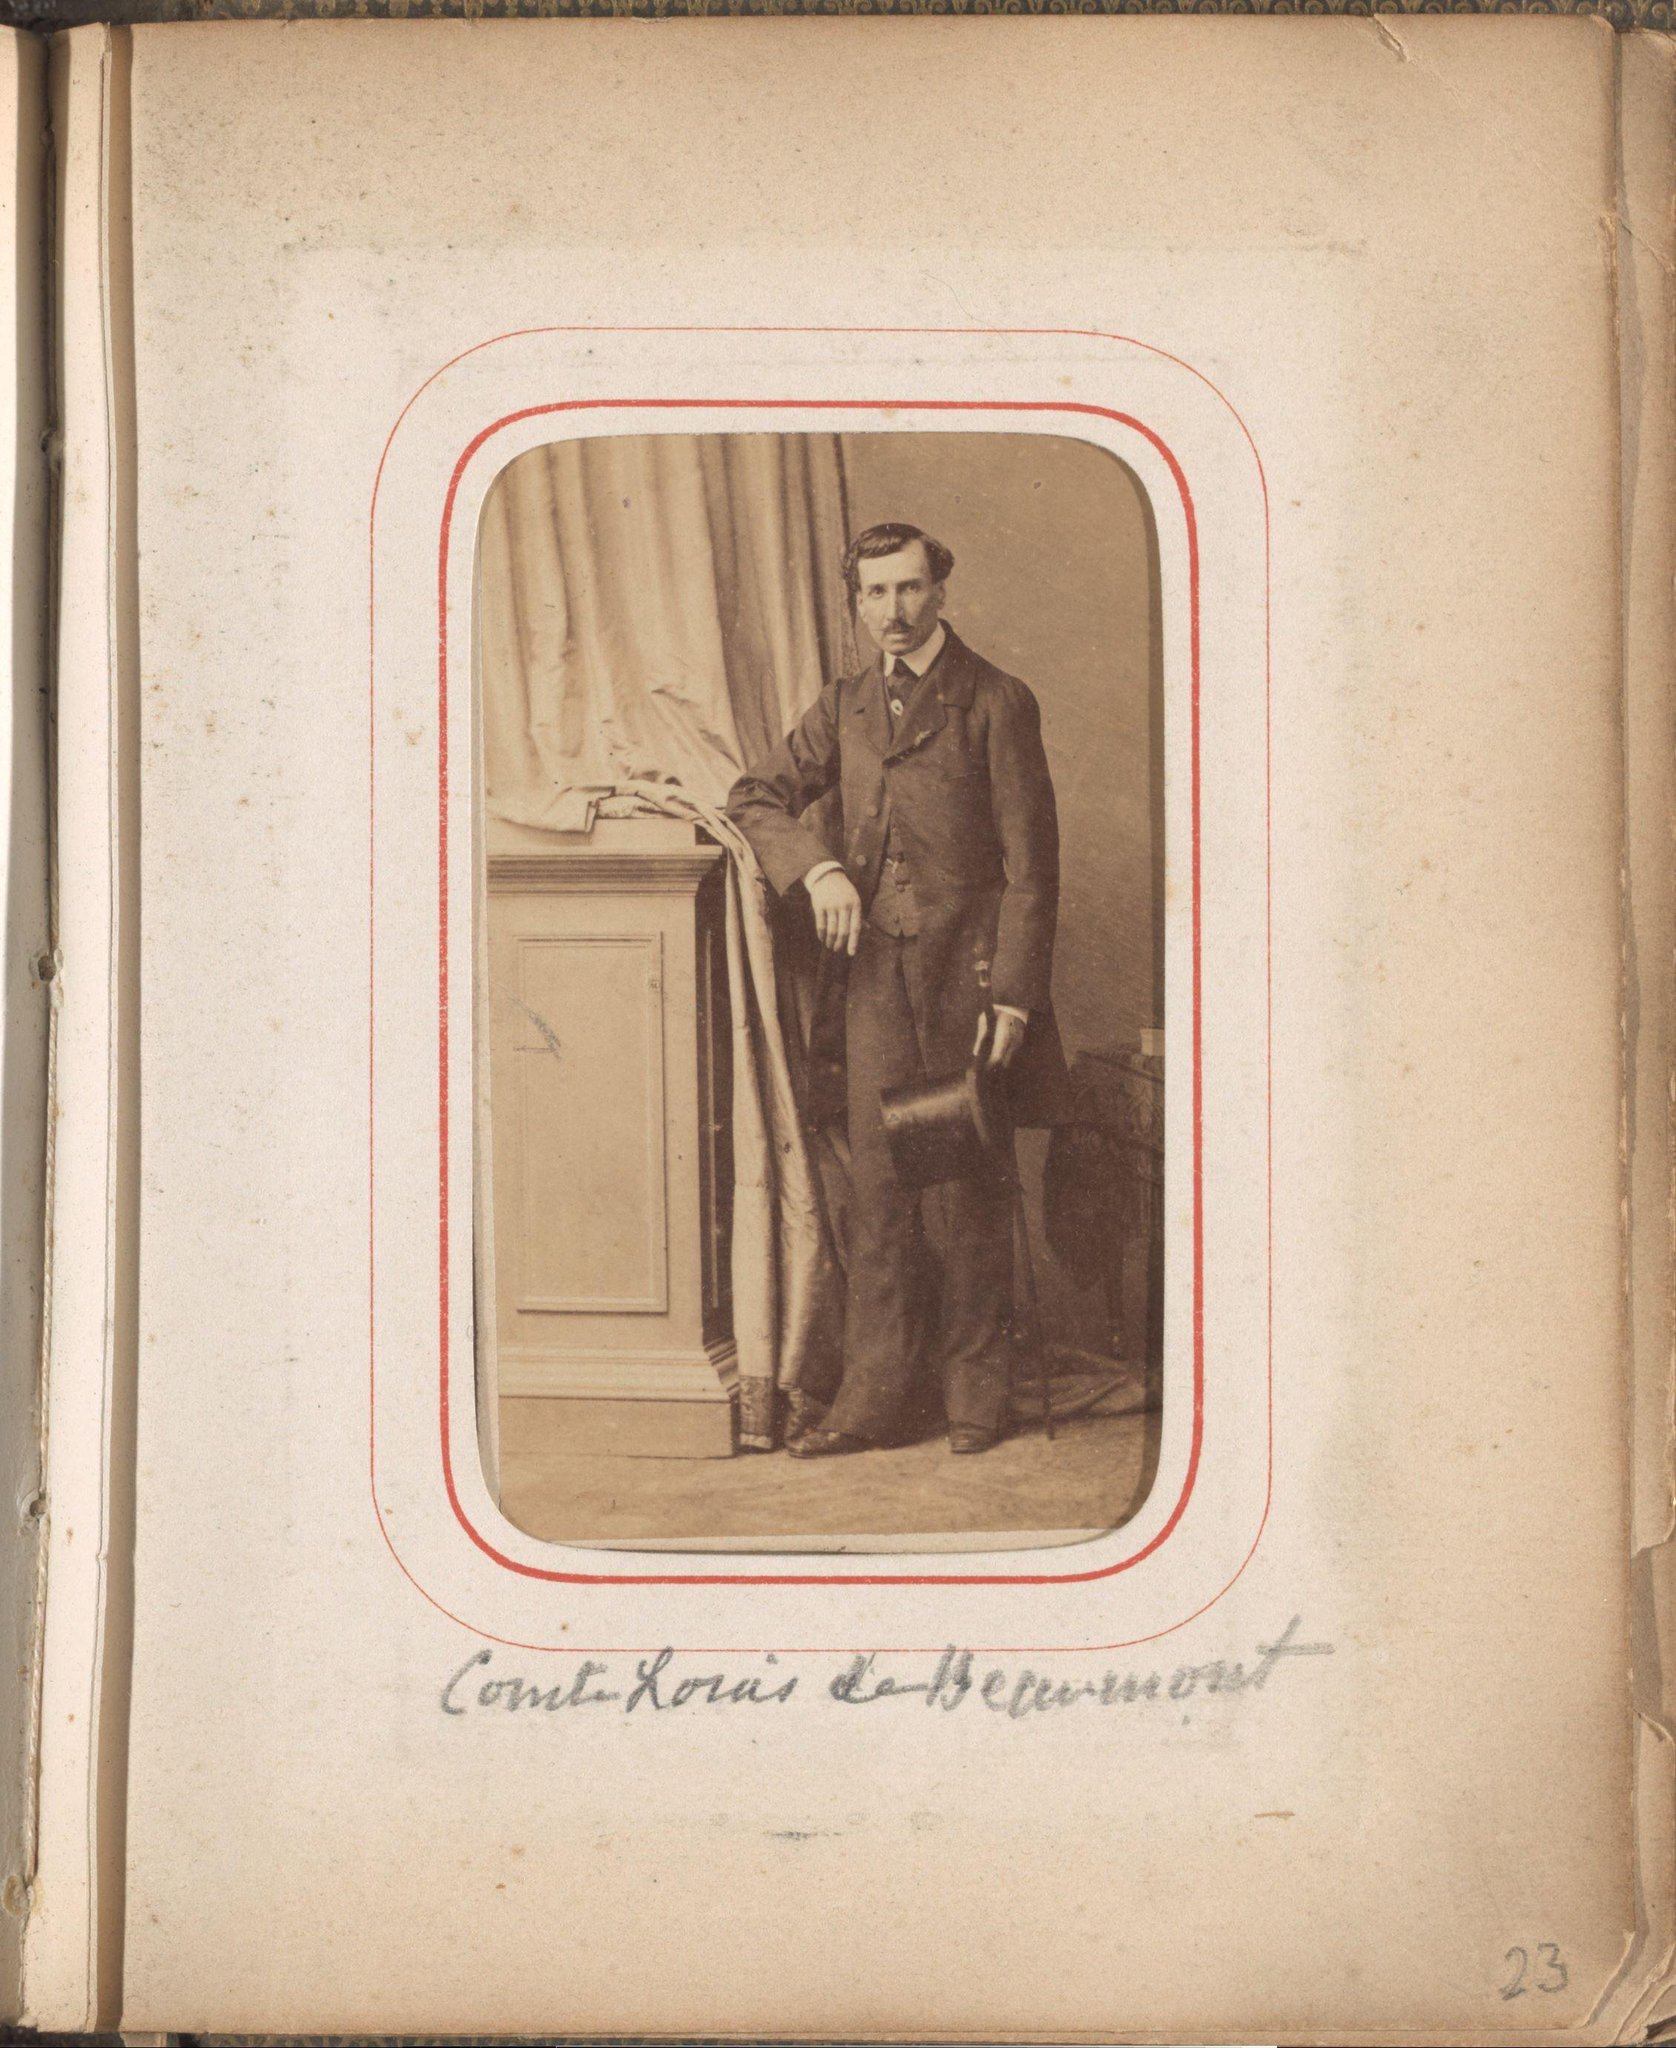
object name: photograph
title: Portret van Louis graaf de Beaumont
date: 1860-1865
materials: cardboard, paper, photographic support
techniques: albumen print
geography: paris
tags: earl, studio requisites ~ photographer, trousers, breeches, walking-stick, staff, moustache, historical persons, shoes, sandals, hairdress, coat, cape, head-gear: top hat, paris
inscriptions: name: ‘Comte Louis de Beaumont’, name: ‘C.te Louis de Beaumont’, address: ‘8, Boulevart des Italiens Paris’